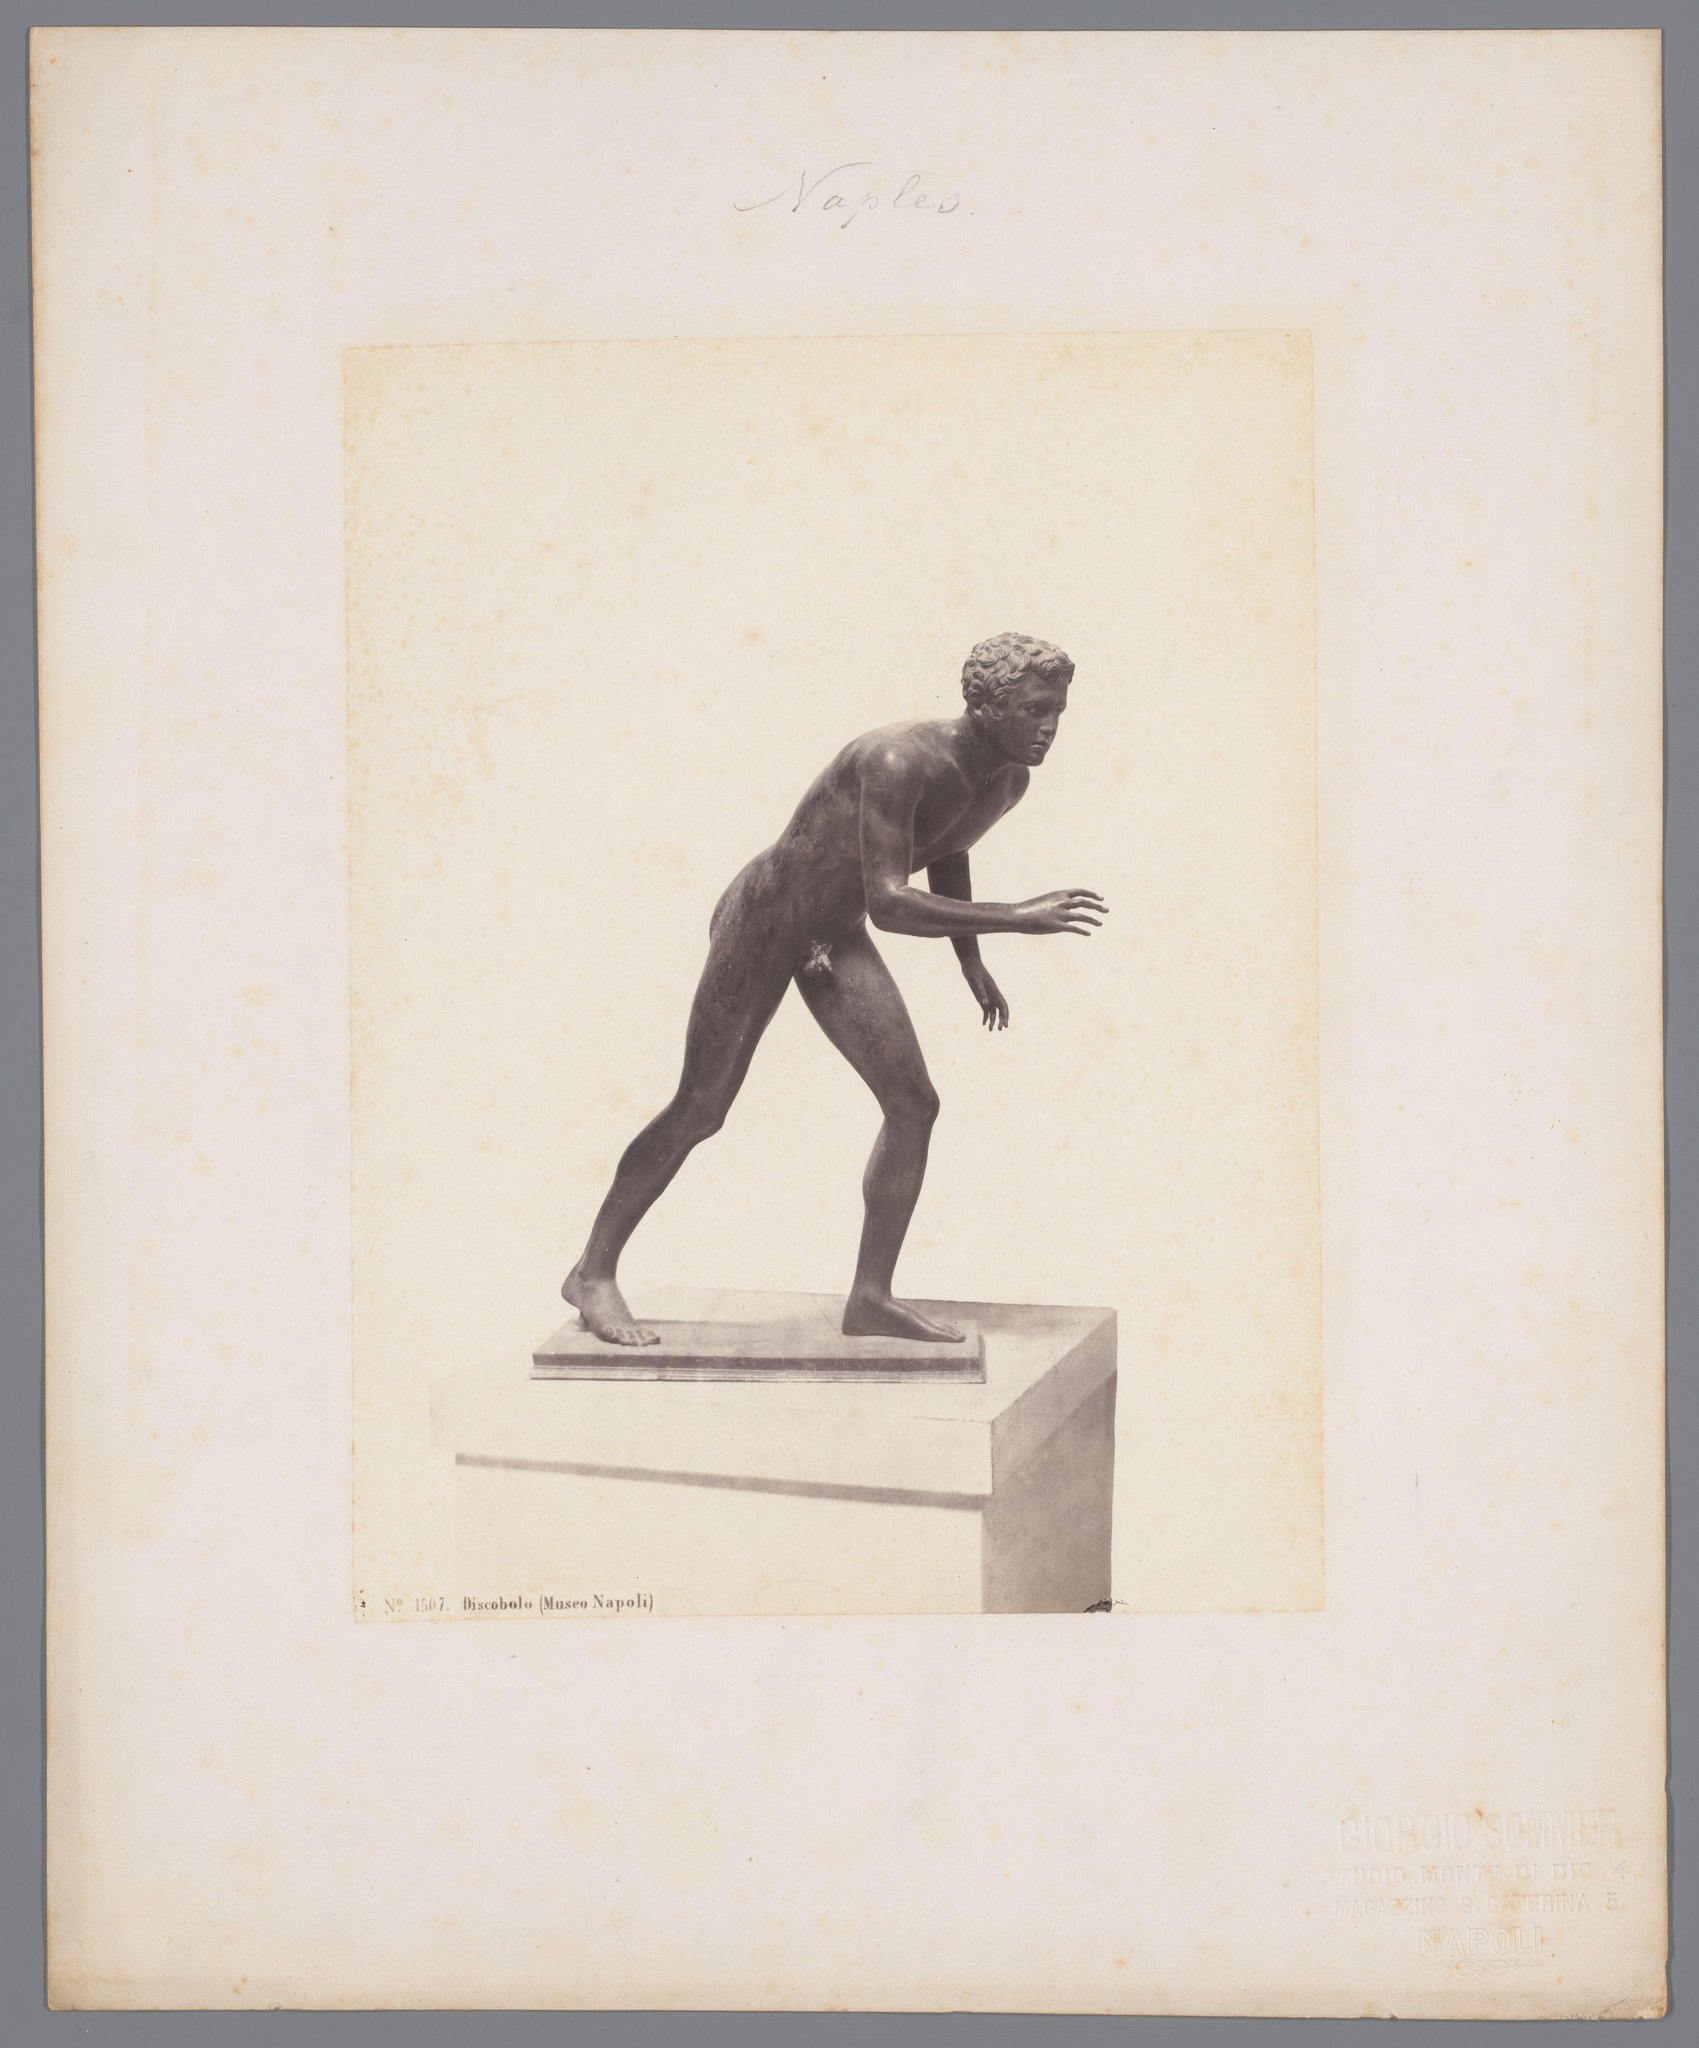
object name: photograph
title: (Museo Napoli)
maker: giorgio sommer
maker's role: fotograaf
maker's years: 1834-1914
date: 1863-1914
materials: cardboard, paper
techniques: albumen print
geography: naples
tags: piece of sculpture, reproduction of a piece of sculpture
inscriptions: number: ‘No. 1507’, address: ‘GIORGIO SOMMER/ STUDIO MONTE DI DIO 4./ MAGAZZINO S. CATERINA 5./ NAPOLI’, inscription: ‘Naples’